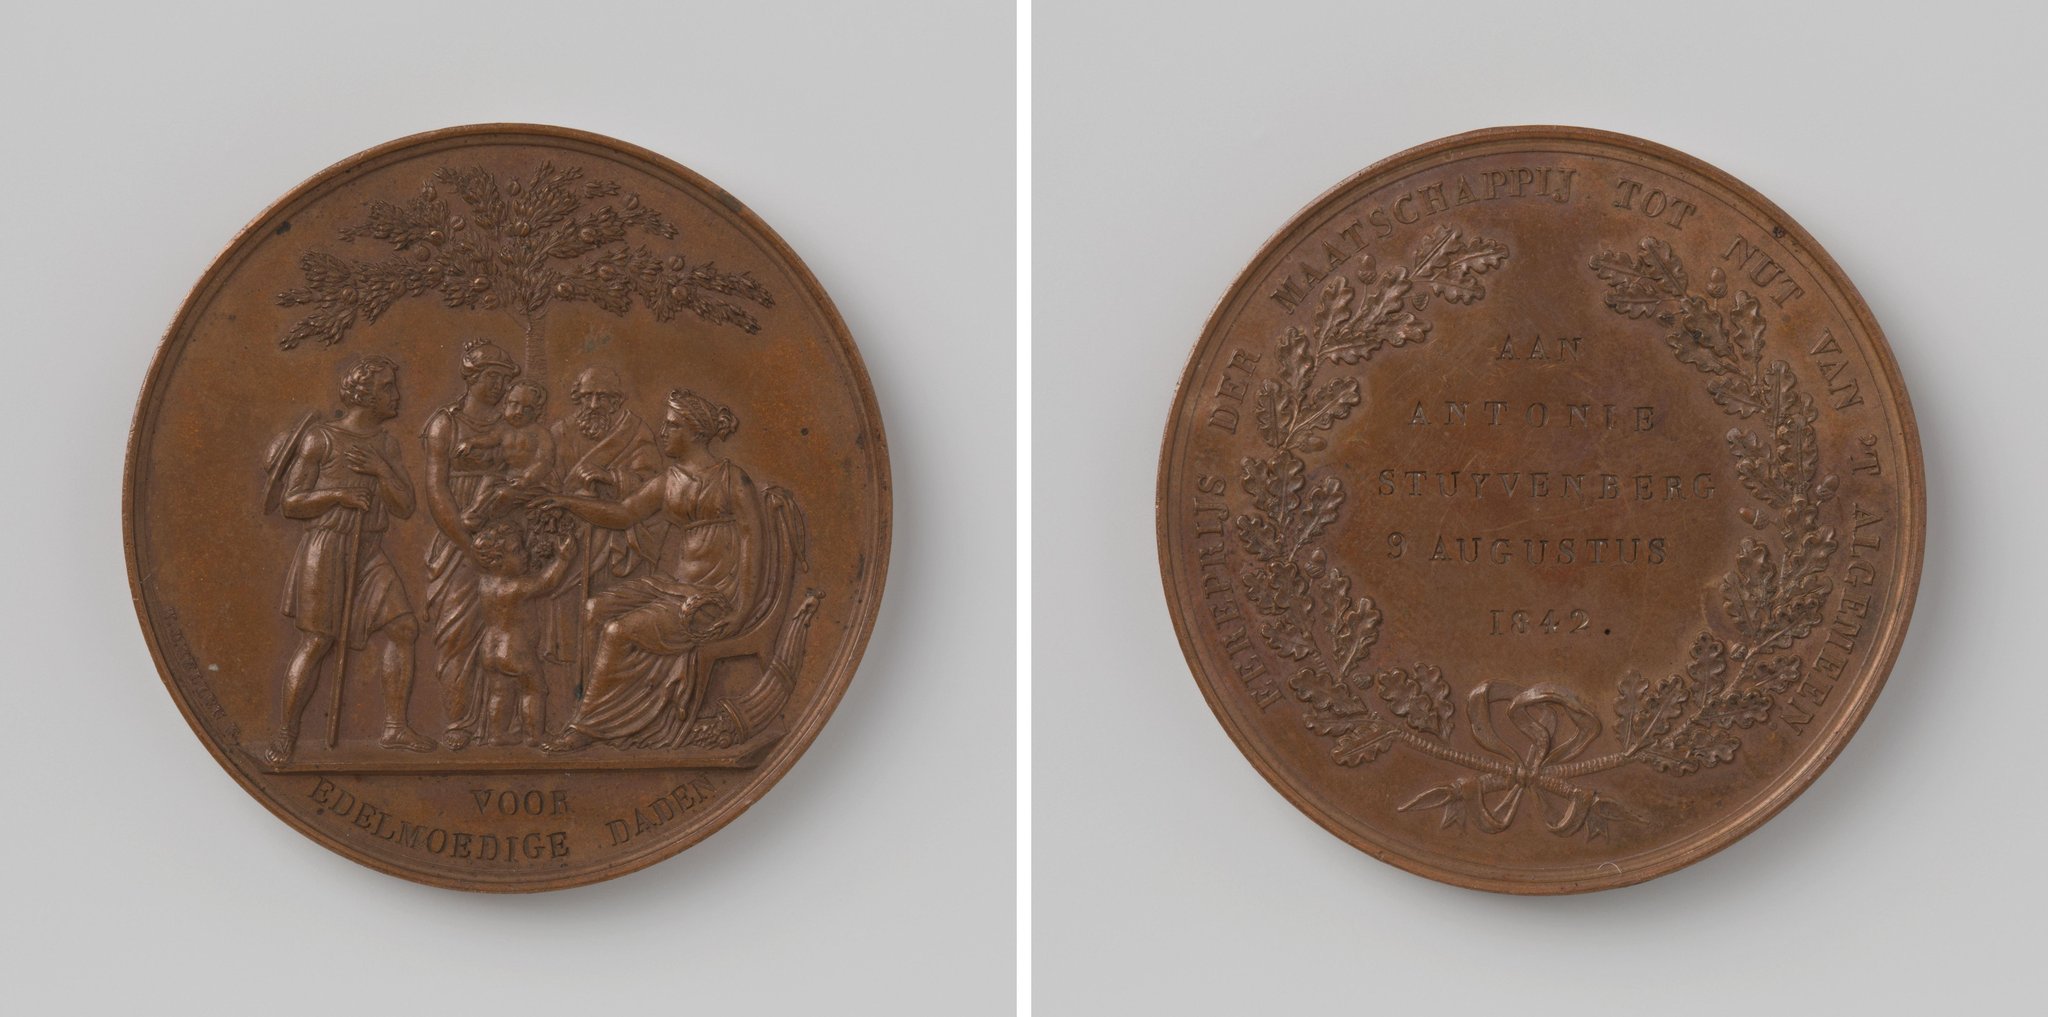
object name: honorary medal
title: Maatschappij tot Nut van 't Algemeen, penning uitgereikt aan Antonie Stuyvenberg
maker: david van der kellen (1804-1879)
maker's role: die cutter, draughtsman, print maker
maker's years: 1804-1879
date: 1842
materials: bronze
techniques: engraving, striking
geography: utrecht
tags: antonie stuyvenberg, maatschappij tot nut van 't algemeen